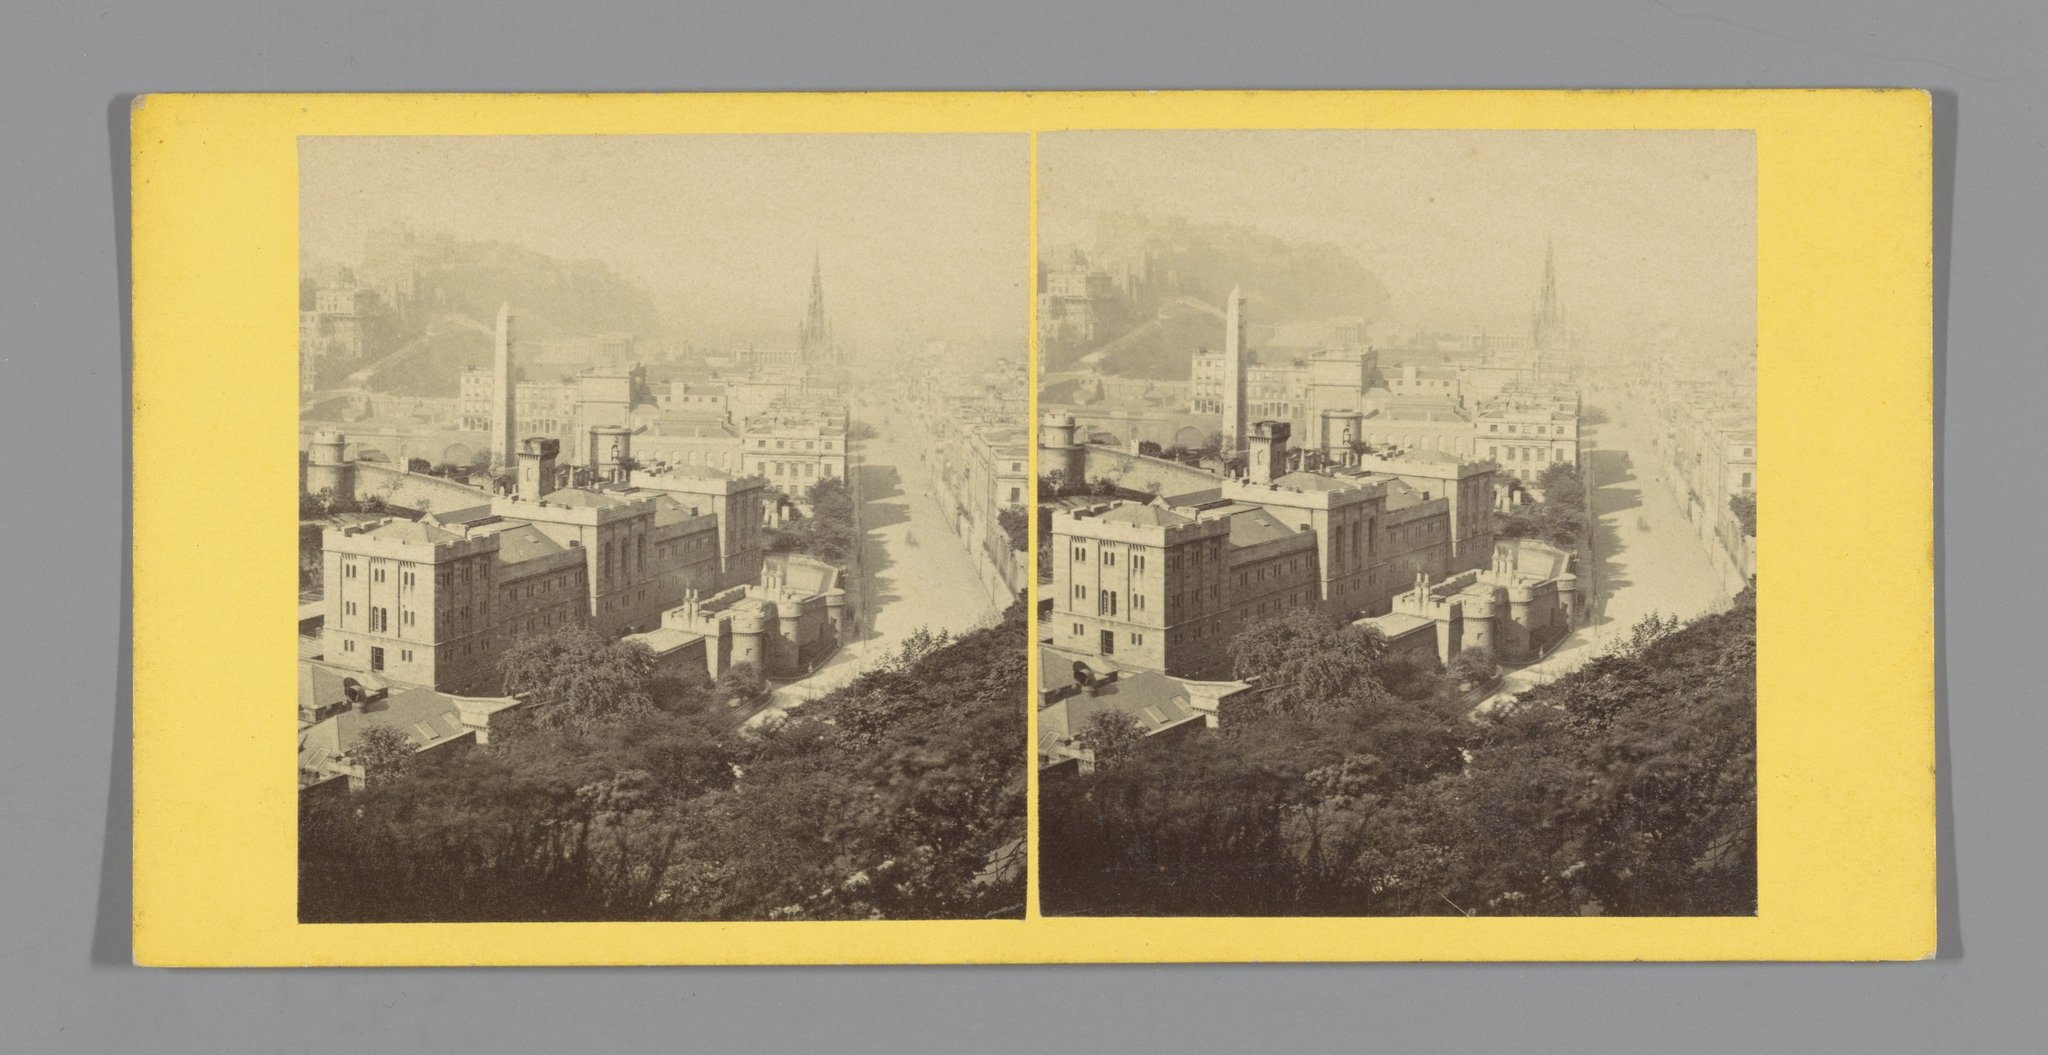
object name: stereograph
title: Gezicht op Edinburgh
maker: george washington wilson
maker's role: publisher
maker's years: 1823-1893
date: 1850-1880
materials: cardboard, photographic support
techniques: albumen print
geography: edinburgh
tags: city-view in general; 'veduta'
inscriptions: name: ‘Registered G. W. Wilson, Photographer, Aberdeen’, number: ‘No. 107.’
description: Het object RP-F-F04807 is vermoedelijk tijdens dezelfde fotografeersessie gemaakt.